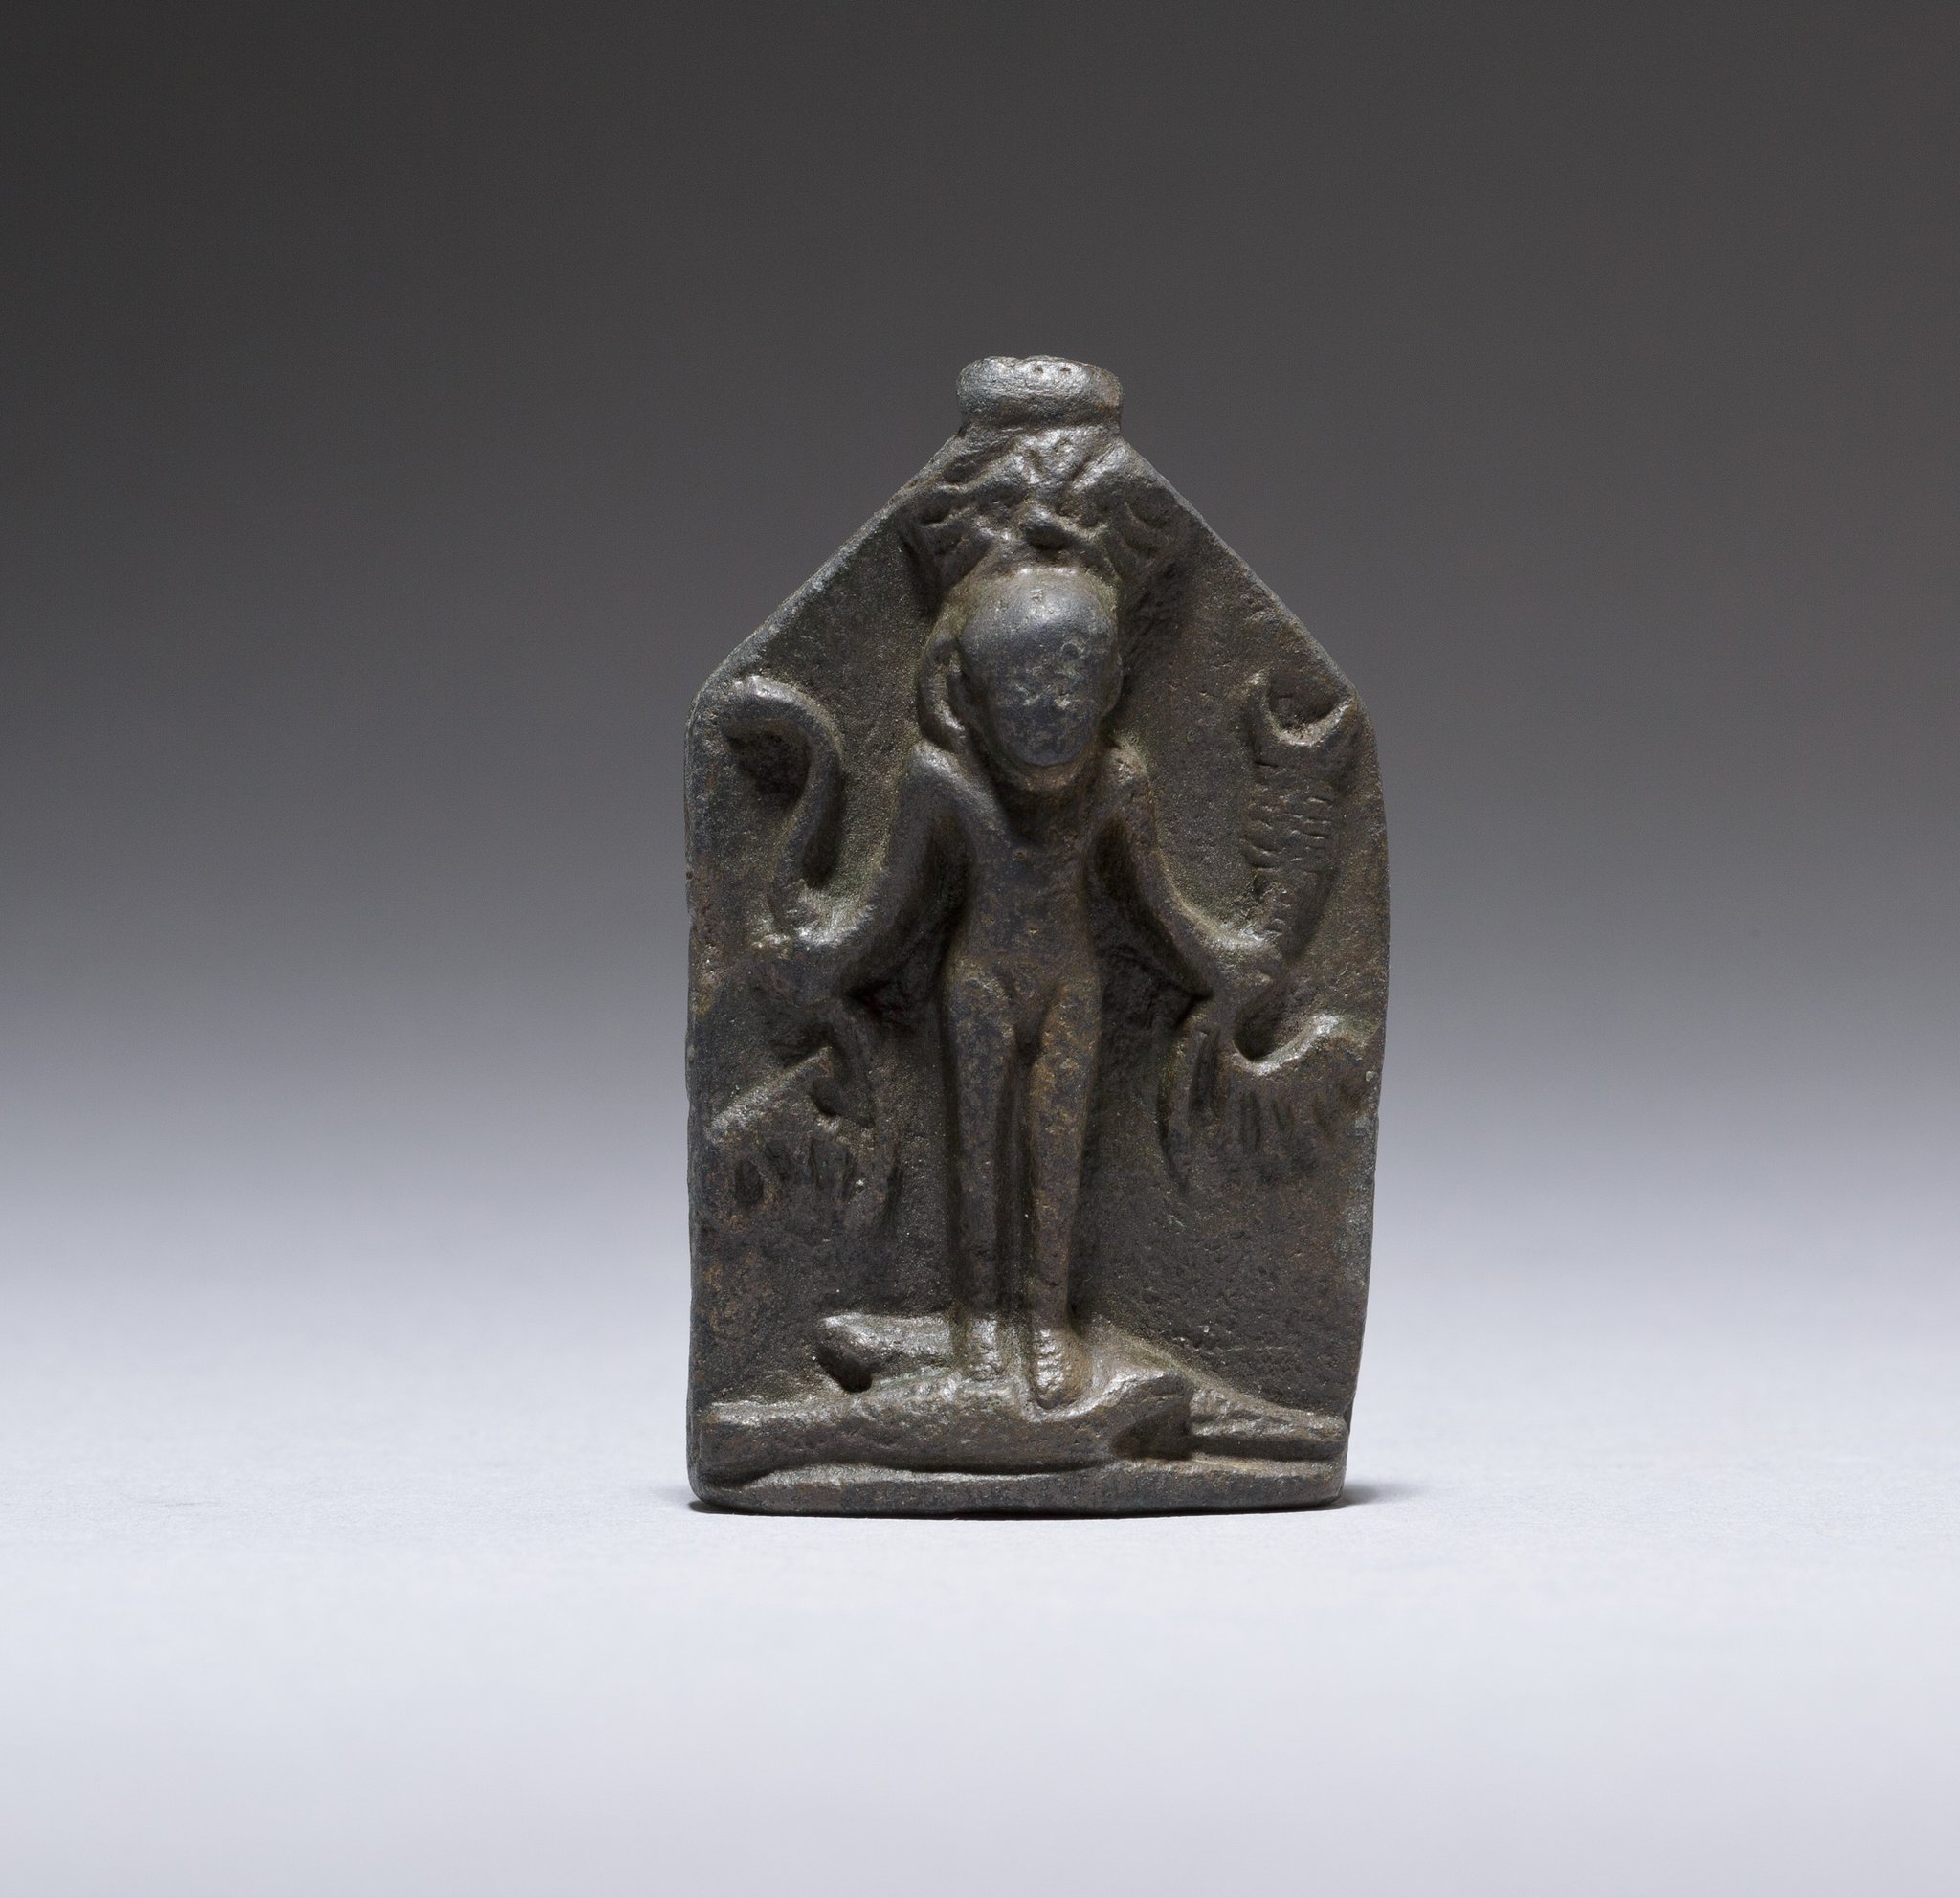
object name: cippus, horus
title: Miniature cippus of Horus (magical stela)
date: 332-330 BCE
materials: metal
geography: egypt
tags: horus,scorpions,lions,snakes